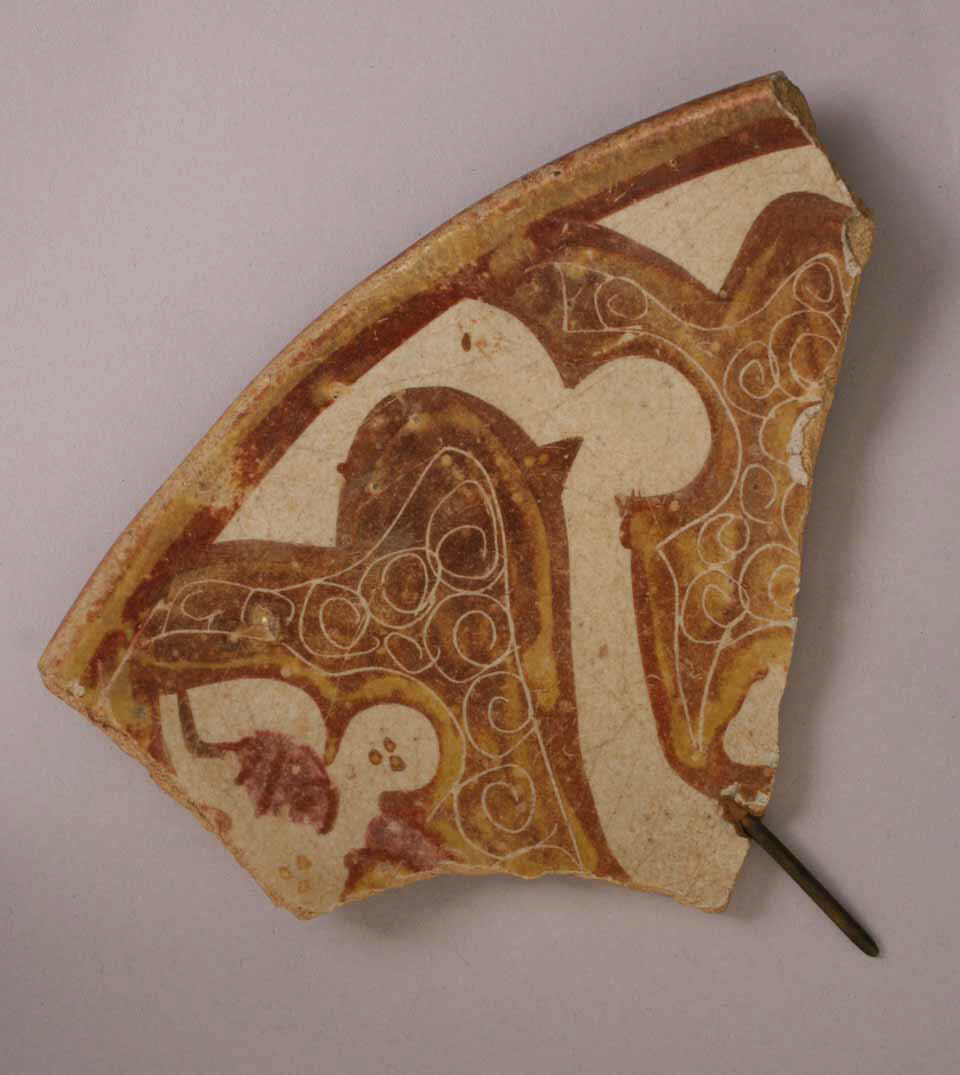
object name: fragment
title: Ceramic Fragment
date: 1001-1200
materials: glaze, stonepaste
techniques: incising, luster painting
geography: egypt